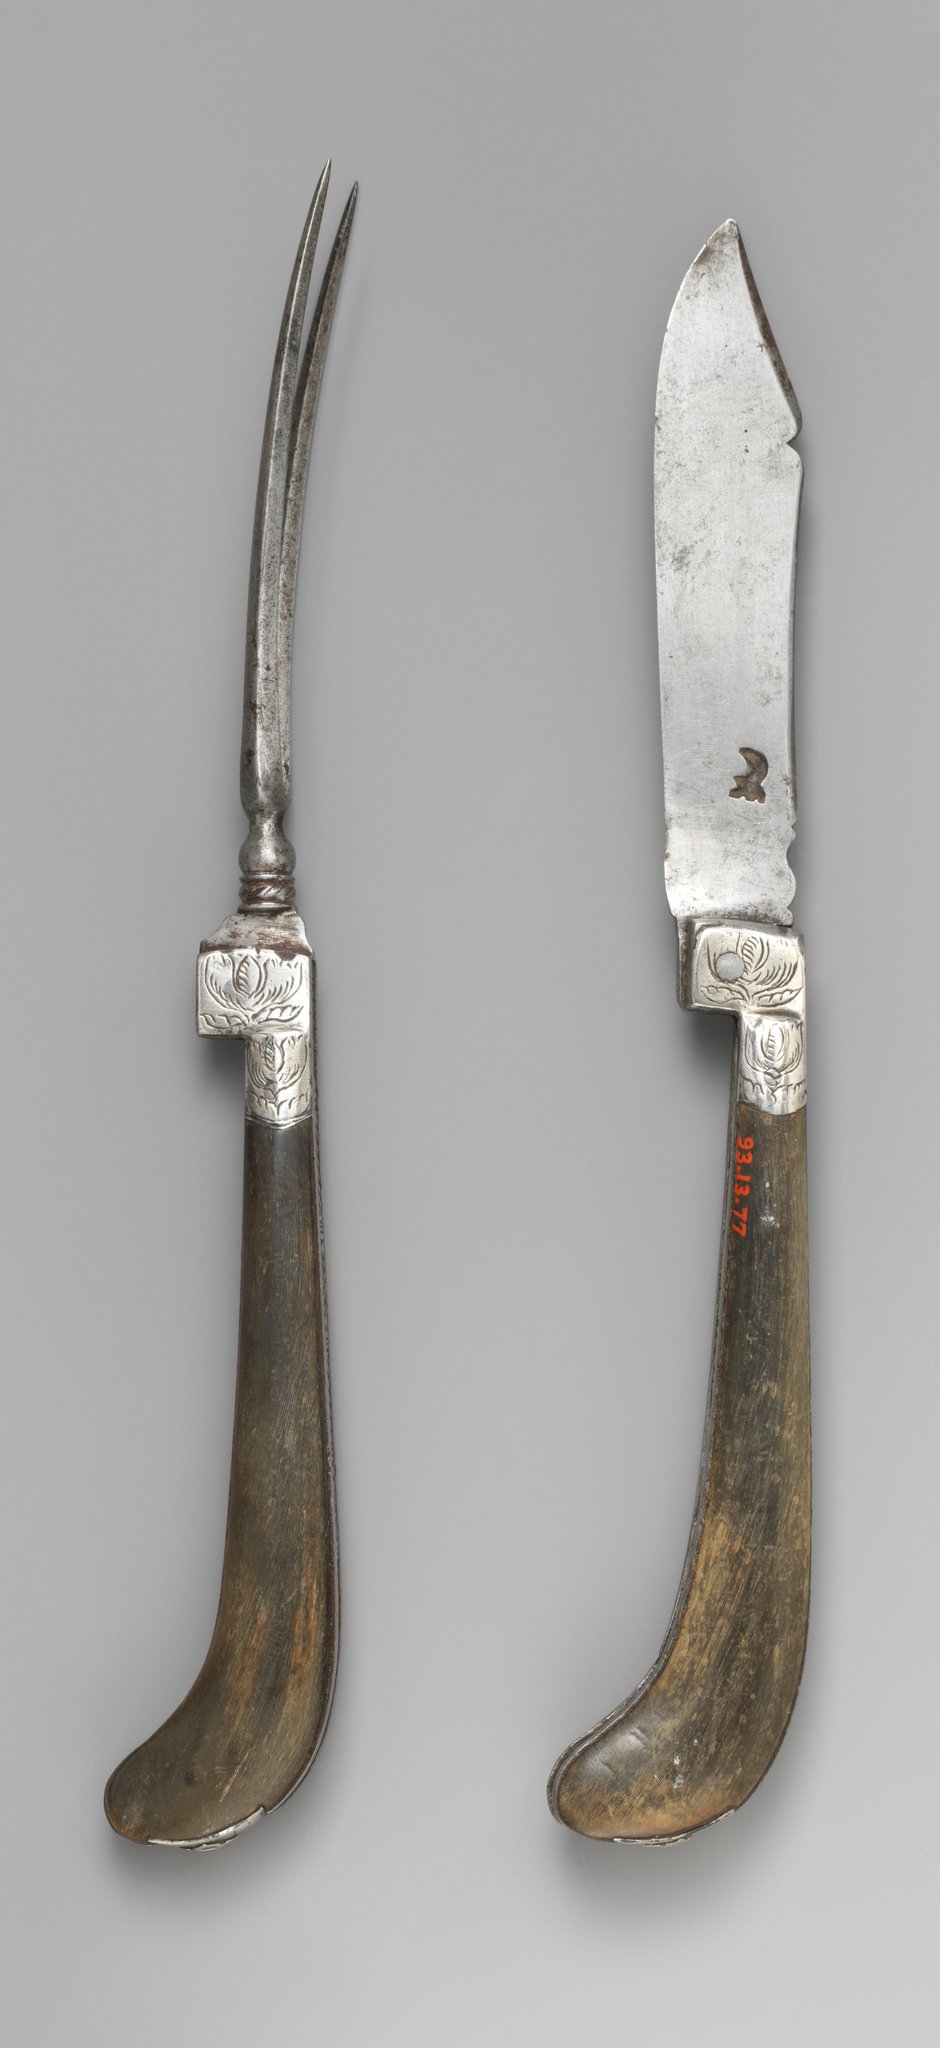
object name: clasp knife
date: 1701-1800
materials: silver, steel